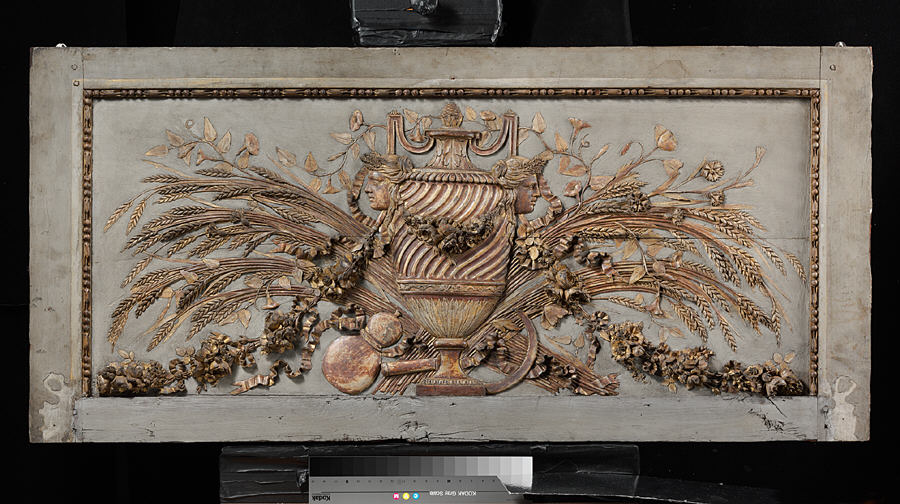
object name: panel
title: Summer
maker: françois joseph belanger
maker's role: maker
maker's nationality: french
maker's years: 1744-1818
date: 1775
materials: gilt, wood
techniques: carving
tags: garlands,vases